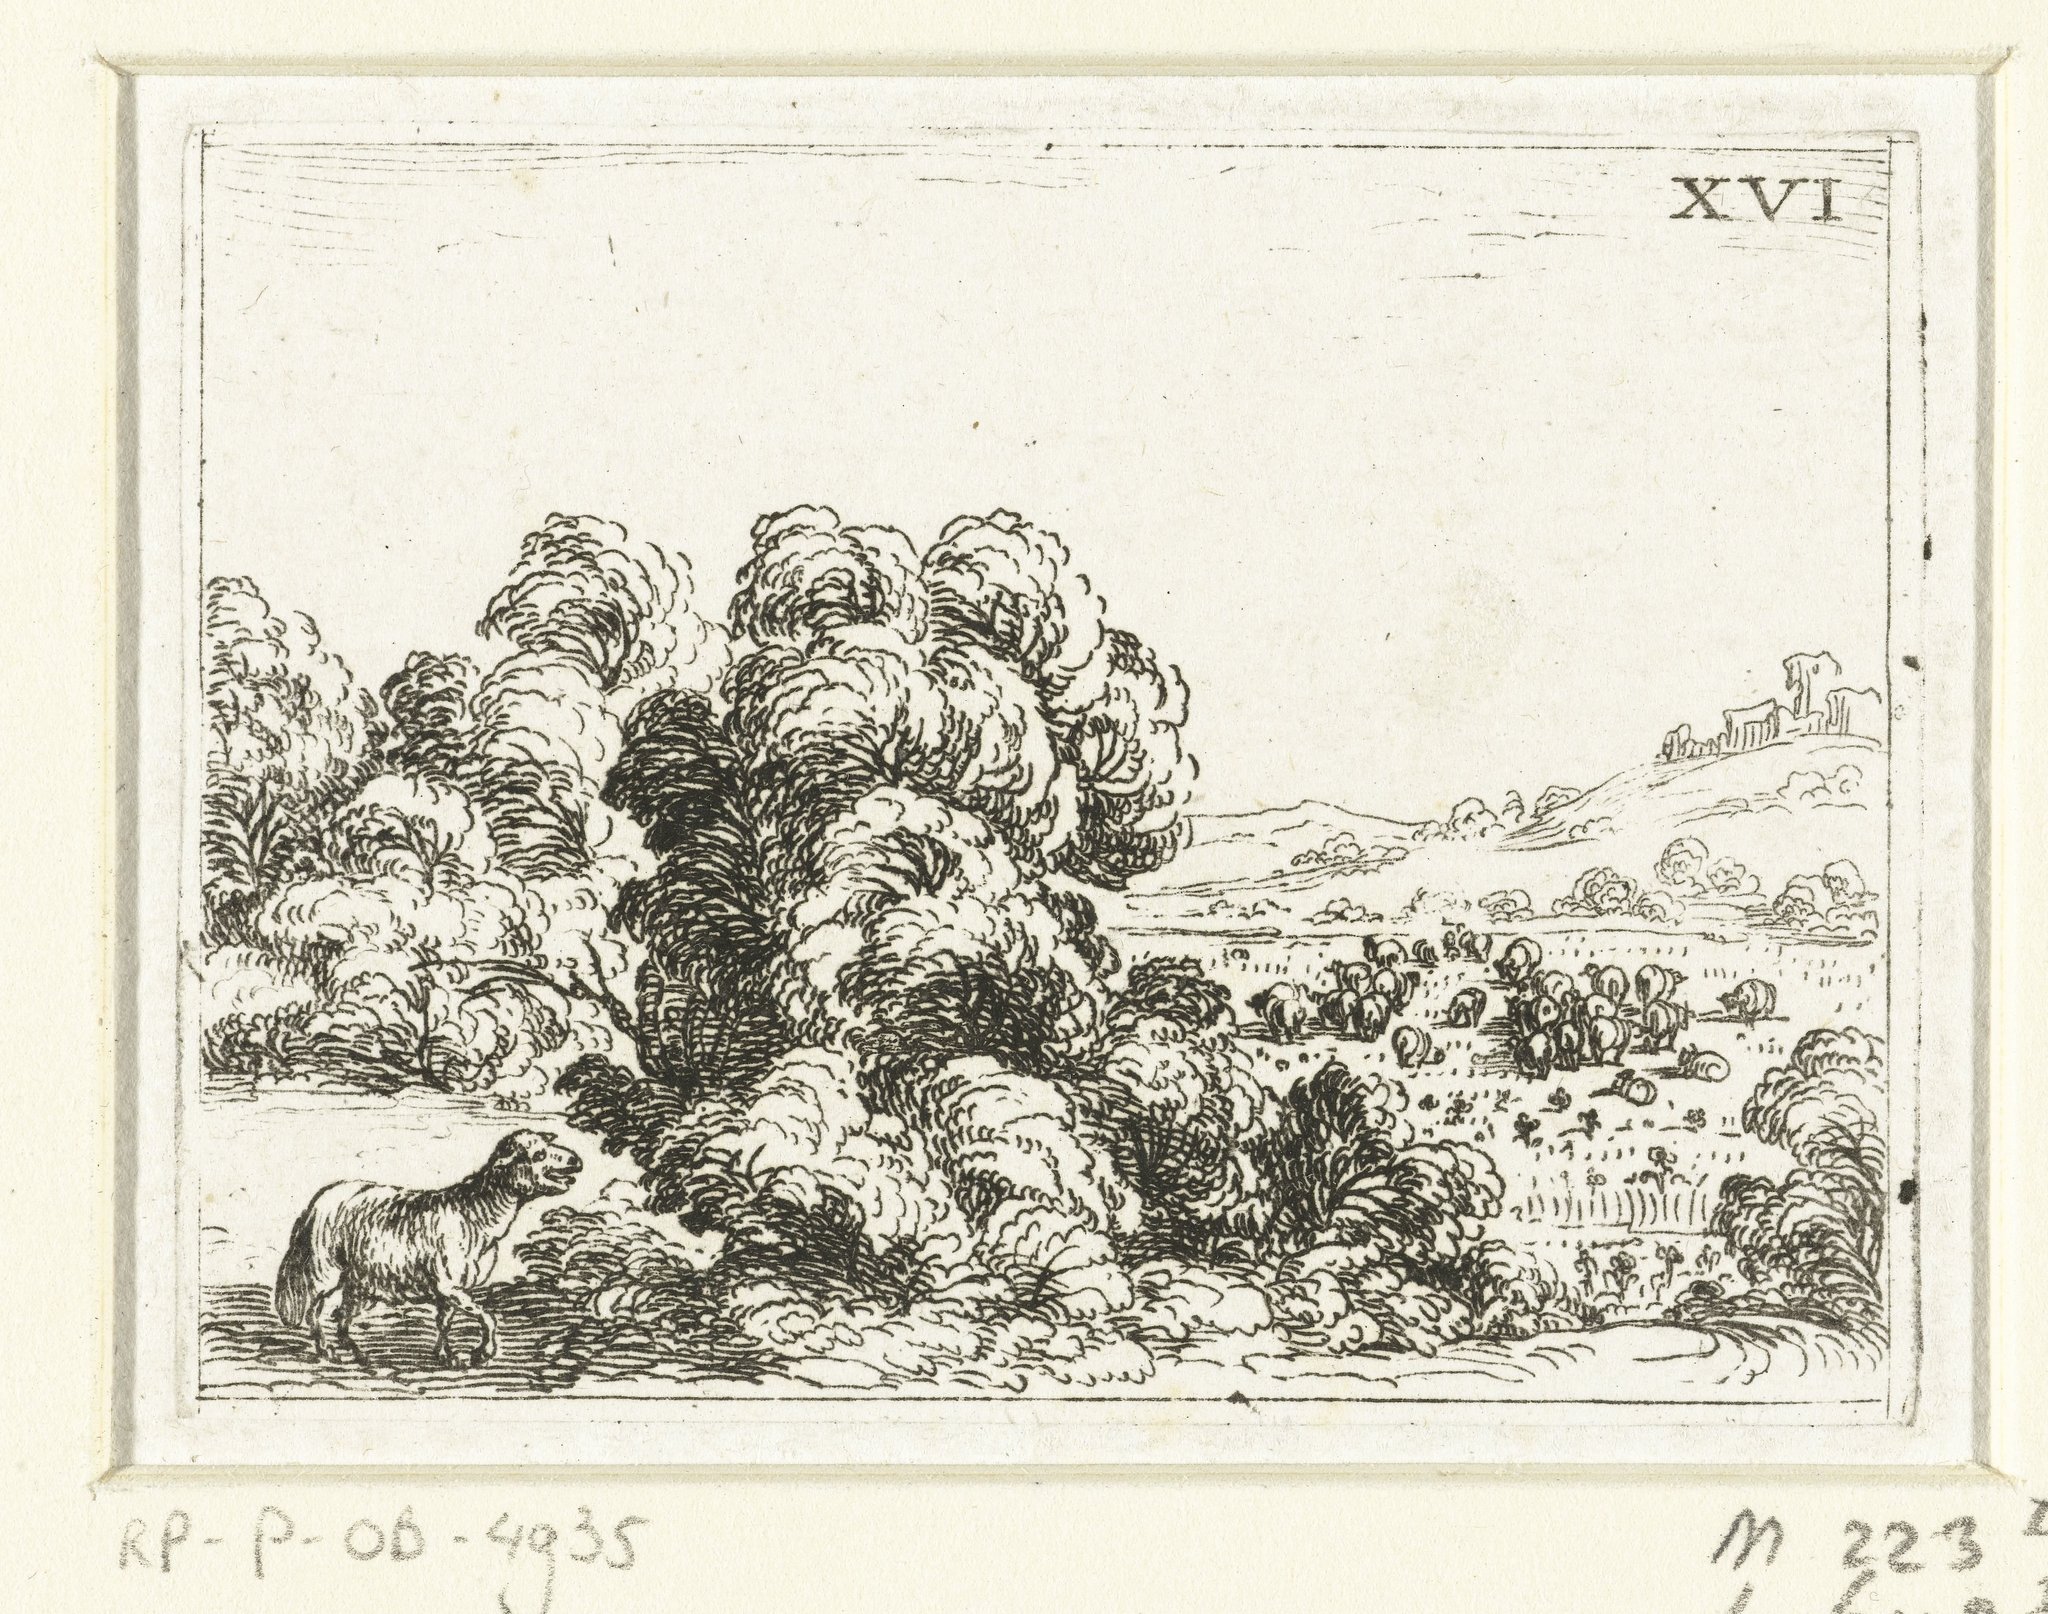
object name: cognizance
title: Een schaap roept haar lam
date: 1625-1629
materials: paper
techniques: etching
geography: paris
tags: sheep, herd, flock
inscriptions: collector's mark: Lugt 240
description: Voorstelling van een blatend schaap, dat van haar kudde gescheiden is door bomen en struikgewas. Dit blad is onderdeel van de embleemserie 'Leven van Maria in emblemen'. De eerste staat van deze serie behelst naast een titelpagina en 26 emblemen ook drie bladen met lofzangen op Maria in boekdruk zonder afbeelding.